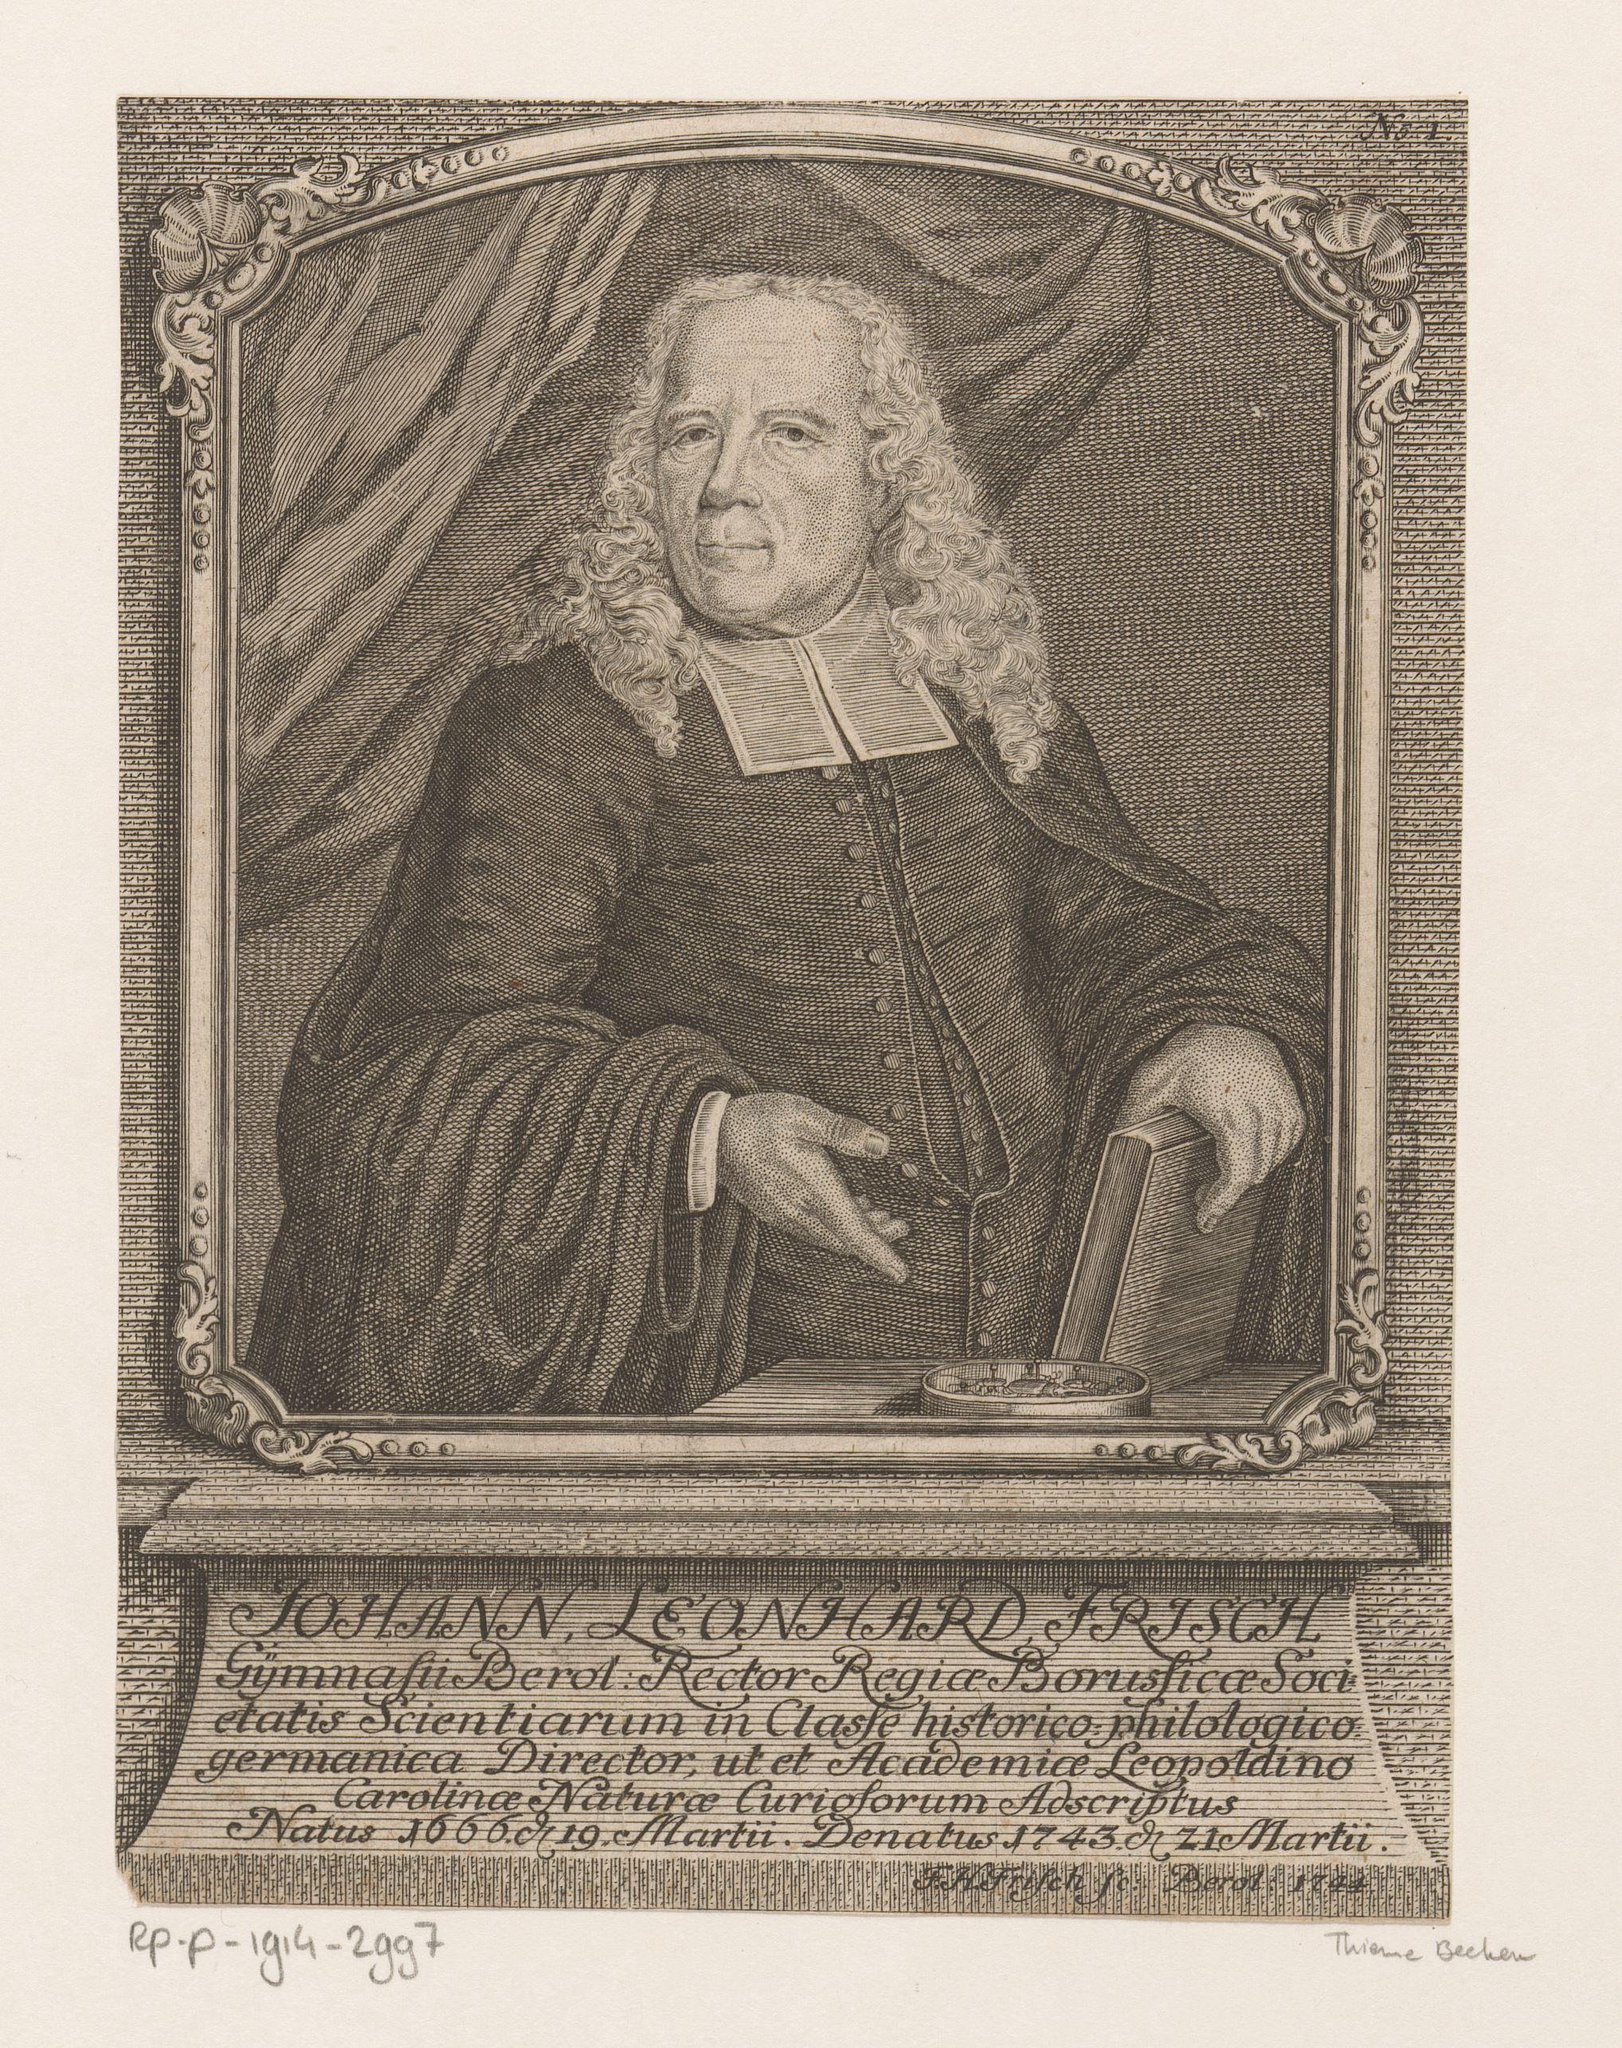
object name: print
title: Portret van Johann Leonhard Frisch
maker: ferdinand helfreich frisch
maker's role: print maker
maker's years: 1707-1758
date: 1744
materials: paper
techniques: engraving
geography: berlin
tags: berlin, physicist, historical persons, book, ornament derived from architectural details, insects: beetle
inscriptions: collector's mark: Lugt 2228